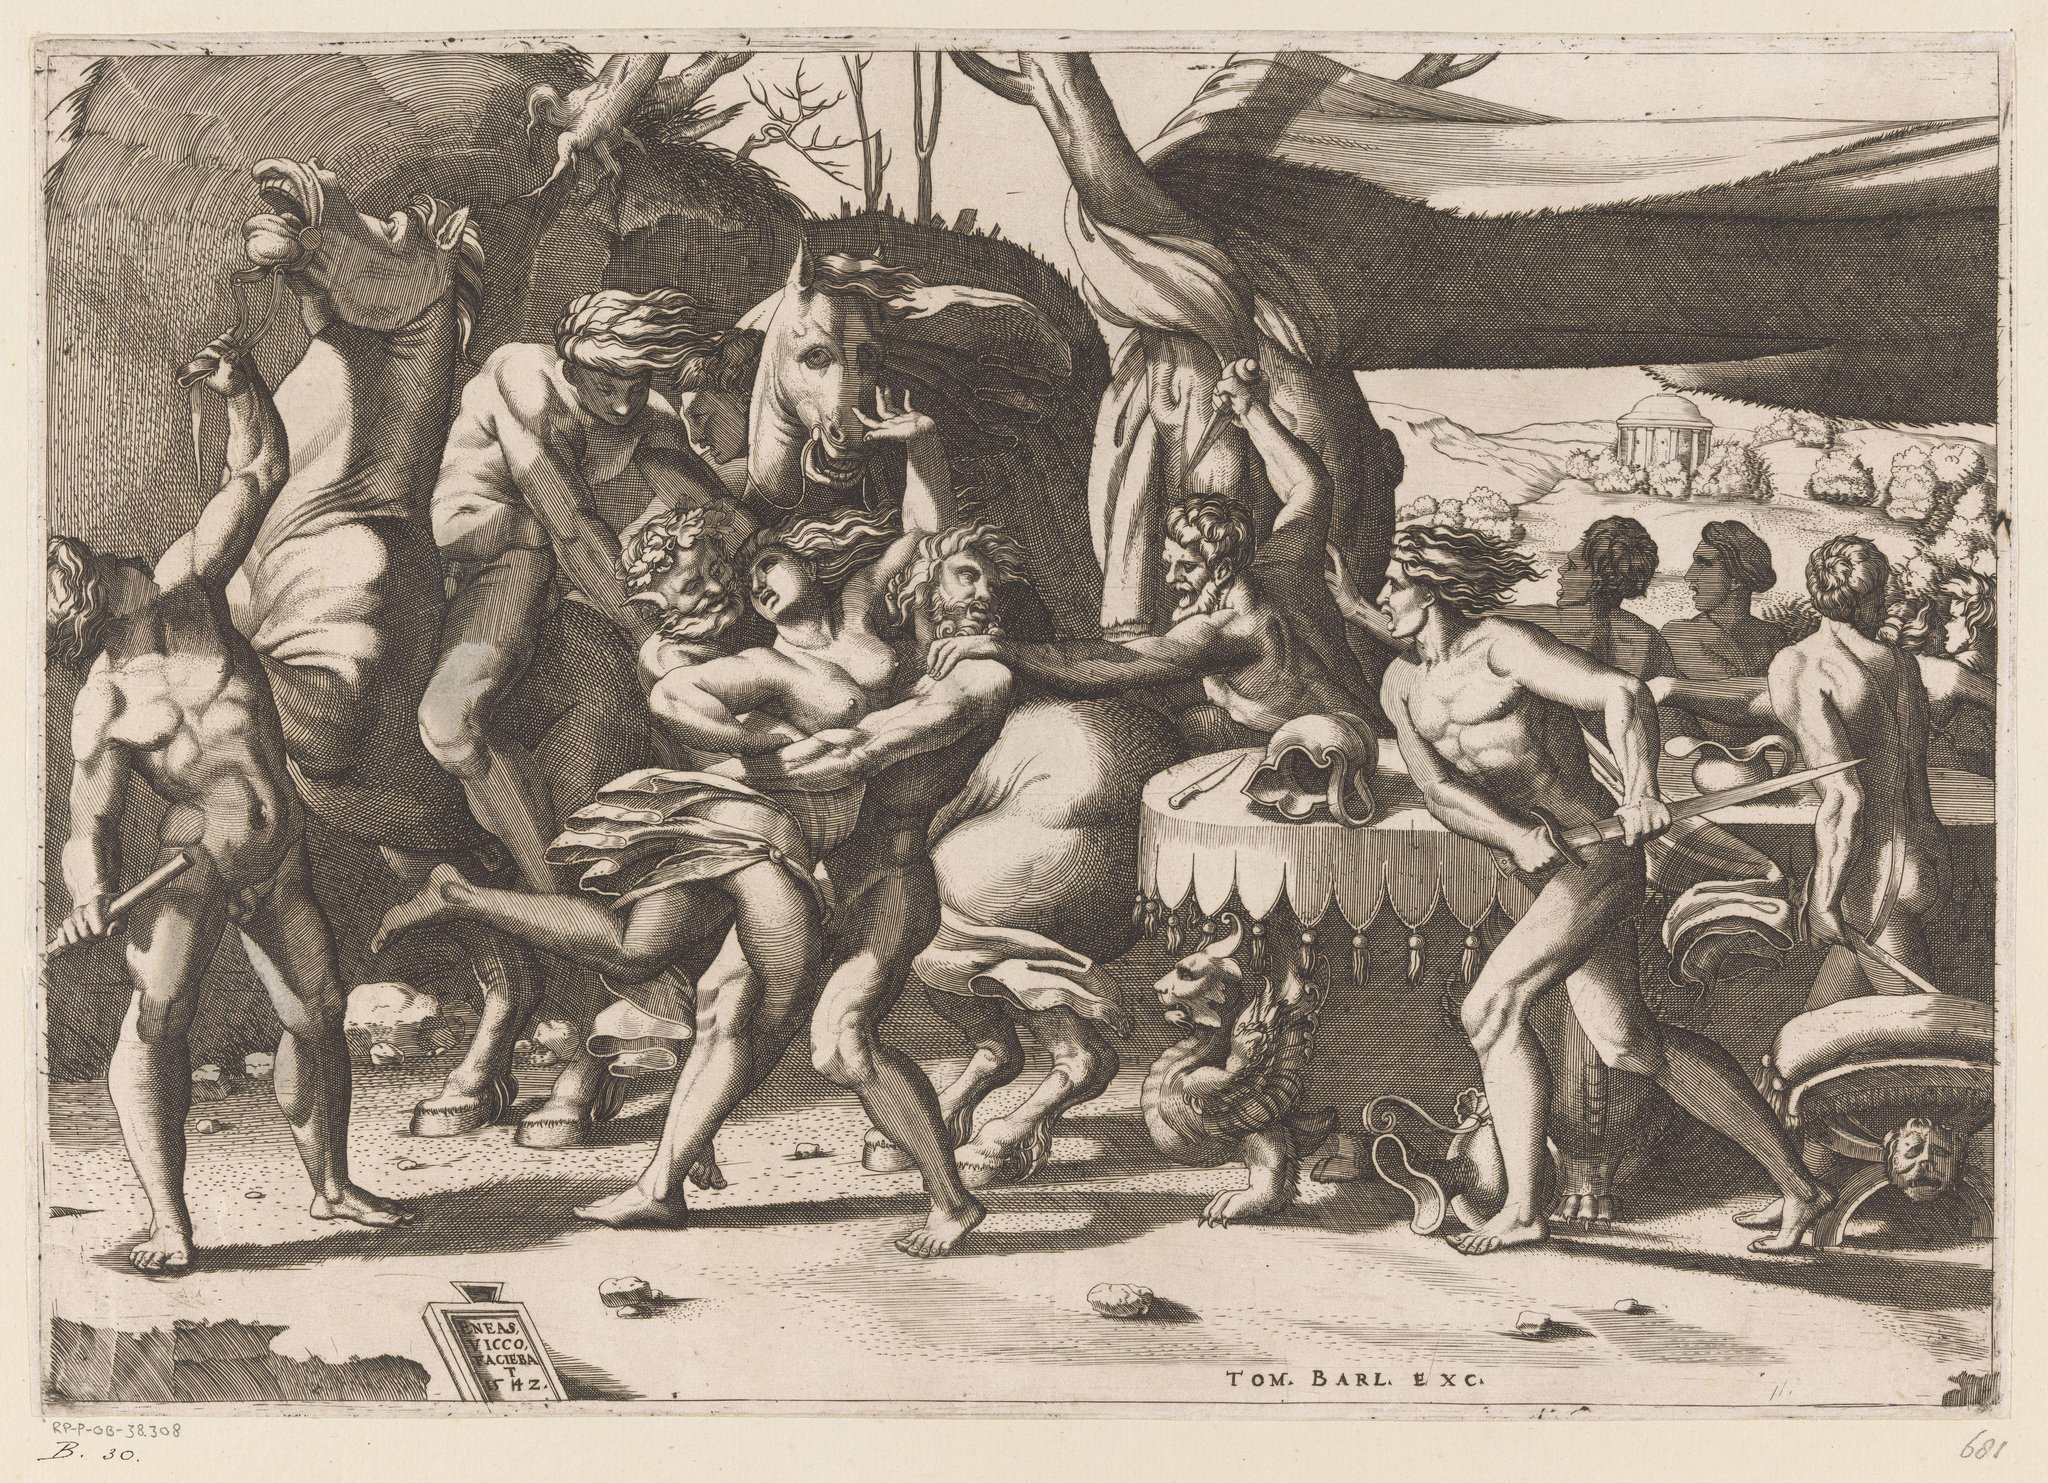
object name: print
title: Roof van een vrouw door man en sater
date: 1542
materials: paper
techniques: engraving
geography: italy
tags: celebration meal, feast, banquet, man abducting woman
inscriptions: collector's mark: Lugt 240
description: In het midden wordt een vrouw geroofd door een man en een sater. Rechts verscheidene figuren rondom een tafel. Op de voorgrond heeft een man zijn zwaard getrokken, en achter de tafel zwaait een man met een dolk. Links twee paarden.